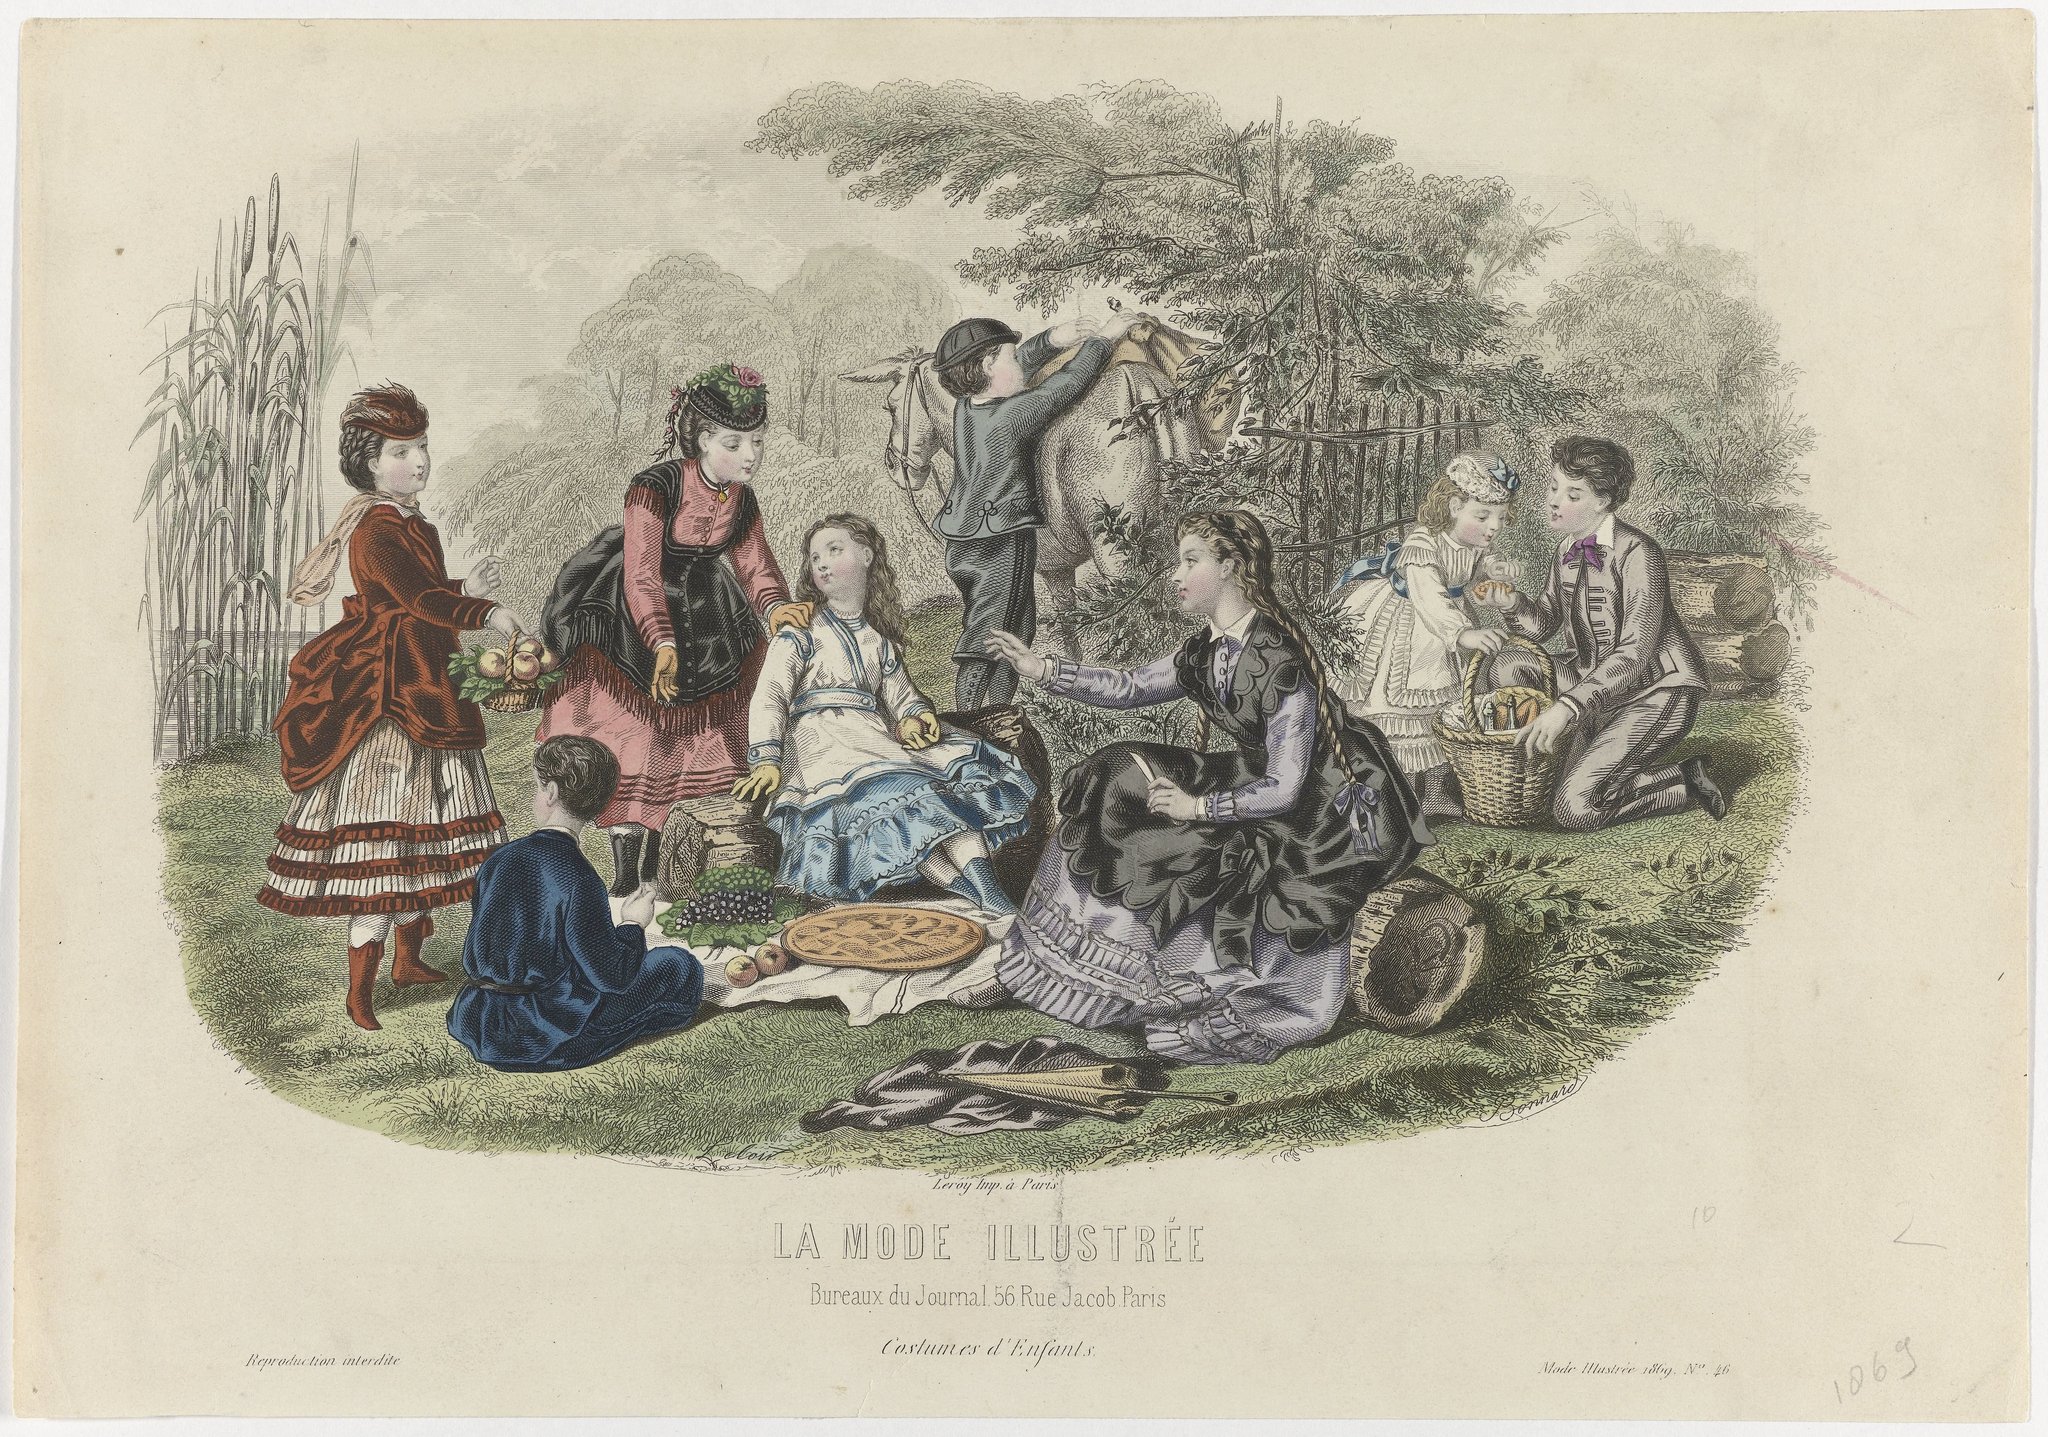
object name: fashion print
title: La Mode Illustrée ,1869, No. 46: Costumes d'Enfants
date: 1869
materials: paper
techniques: engraving, hand coloring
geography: paris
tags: ass, donkey, trousers, breeches (+ boys' clothes), head-gear (+ girls' clothes), neck-gear ~ clothing (+ girls' clothes), clothing for the upper part of the body (+ boys' clothes), boots (+ girls' clothes), parasol, sunshade (+ girls' clothes), head-gear (+ boys' clothes), fashion plates, (family) meal - cc - out of doors, fruits, dress, gown (+ girls' clothes)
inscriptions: address: ‘Bureaux du Journal, 56, Rue Jacob. Paris’, caption: ‘Costumes d'Enfants’, title: ‘La Mode Illustrée’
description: Vijf meisjes en drie jongens zijn aan het picknicken. Prent uit het modetijdschrift La Mode Illustrée (1860-1937).